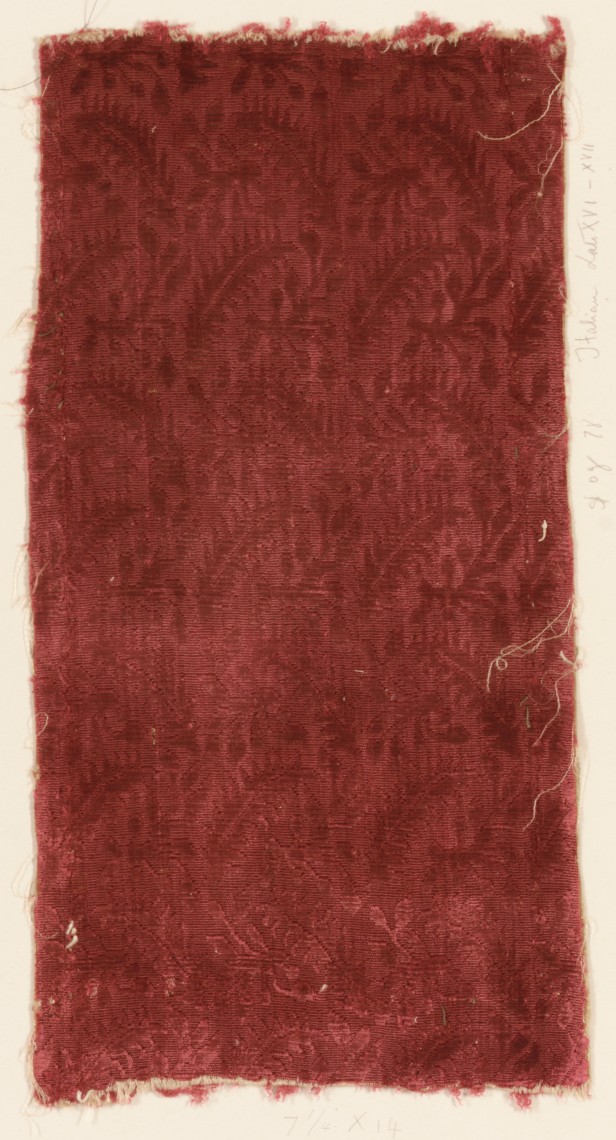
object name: fragment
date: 1567-1700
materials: silk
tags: leaves